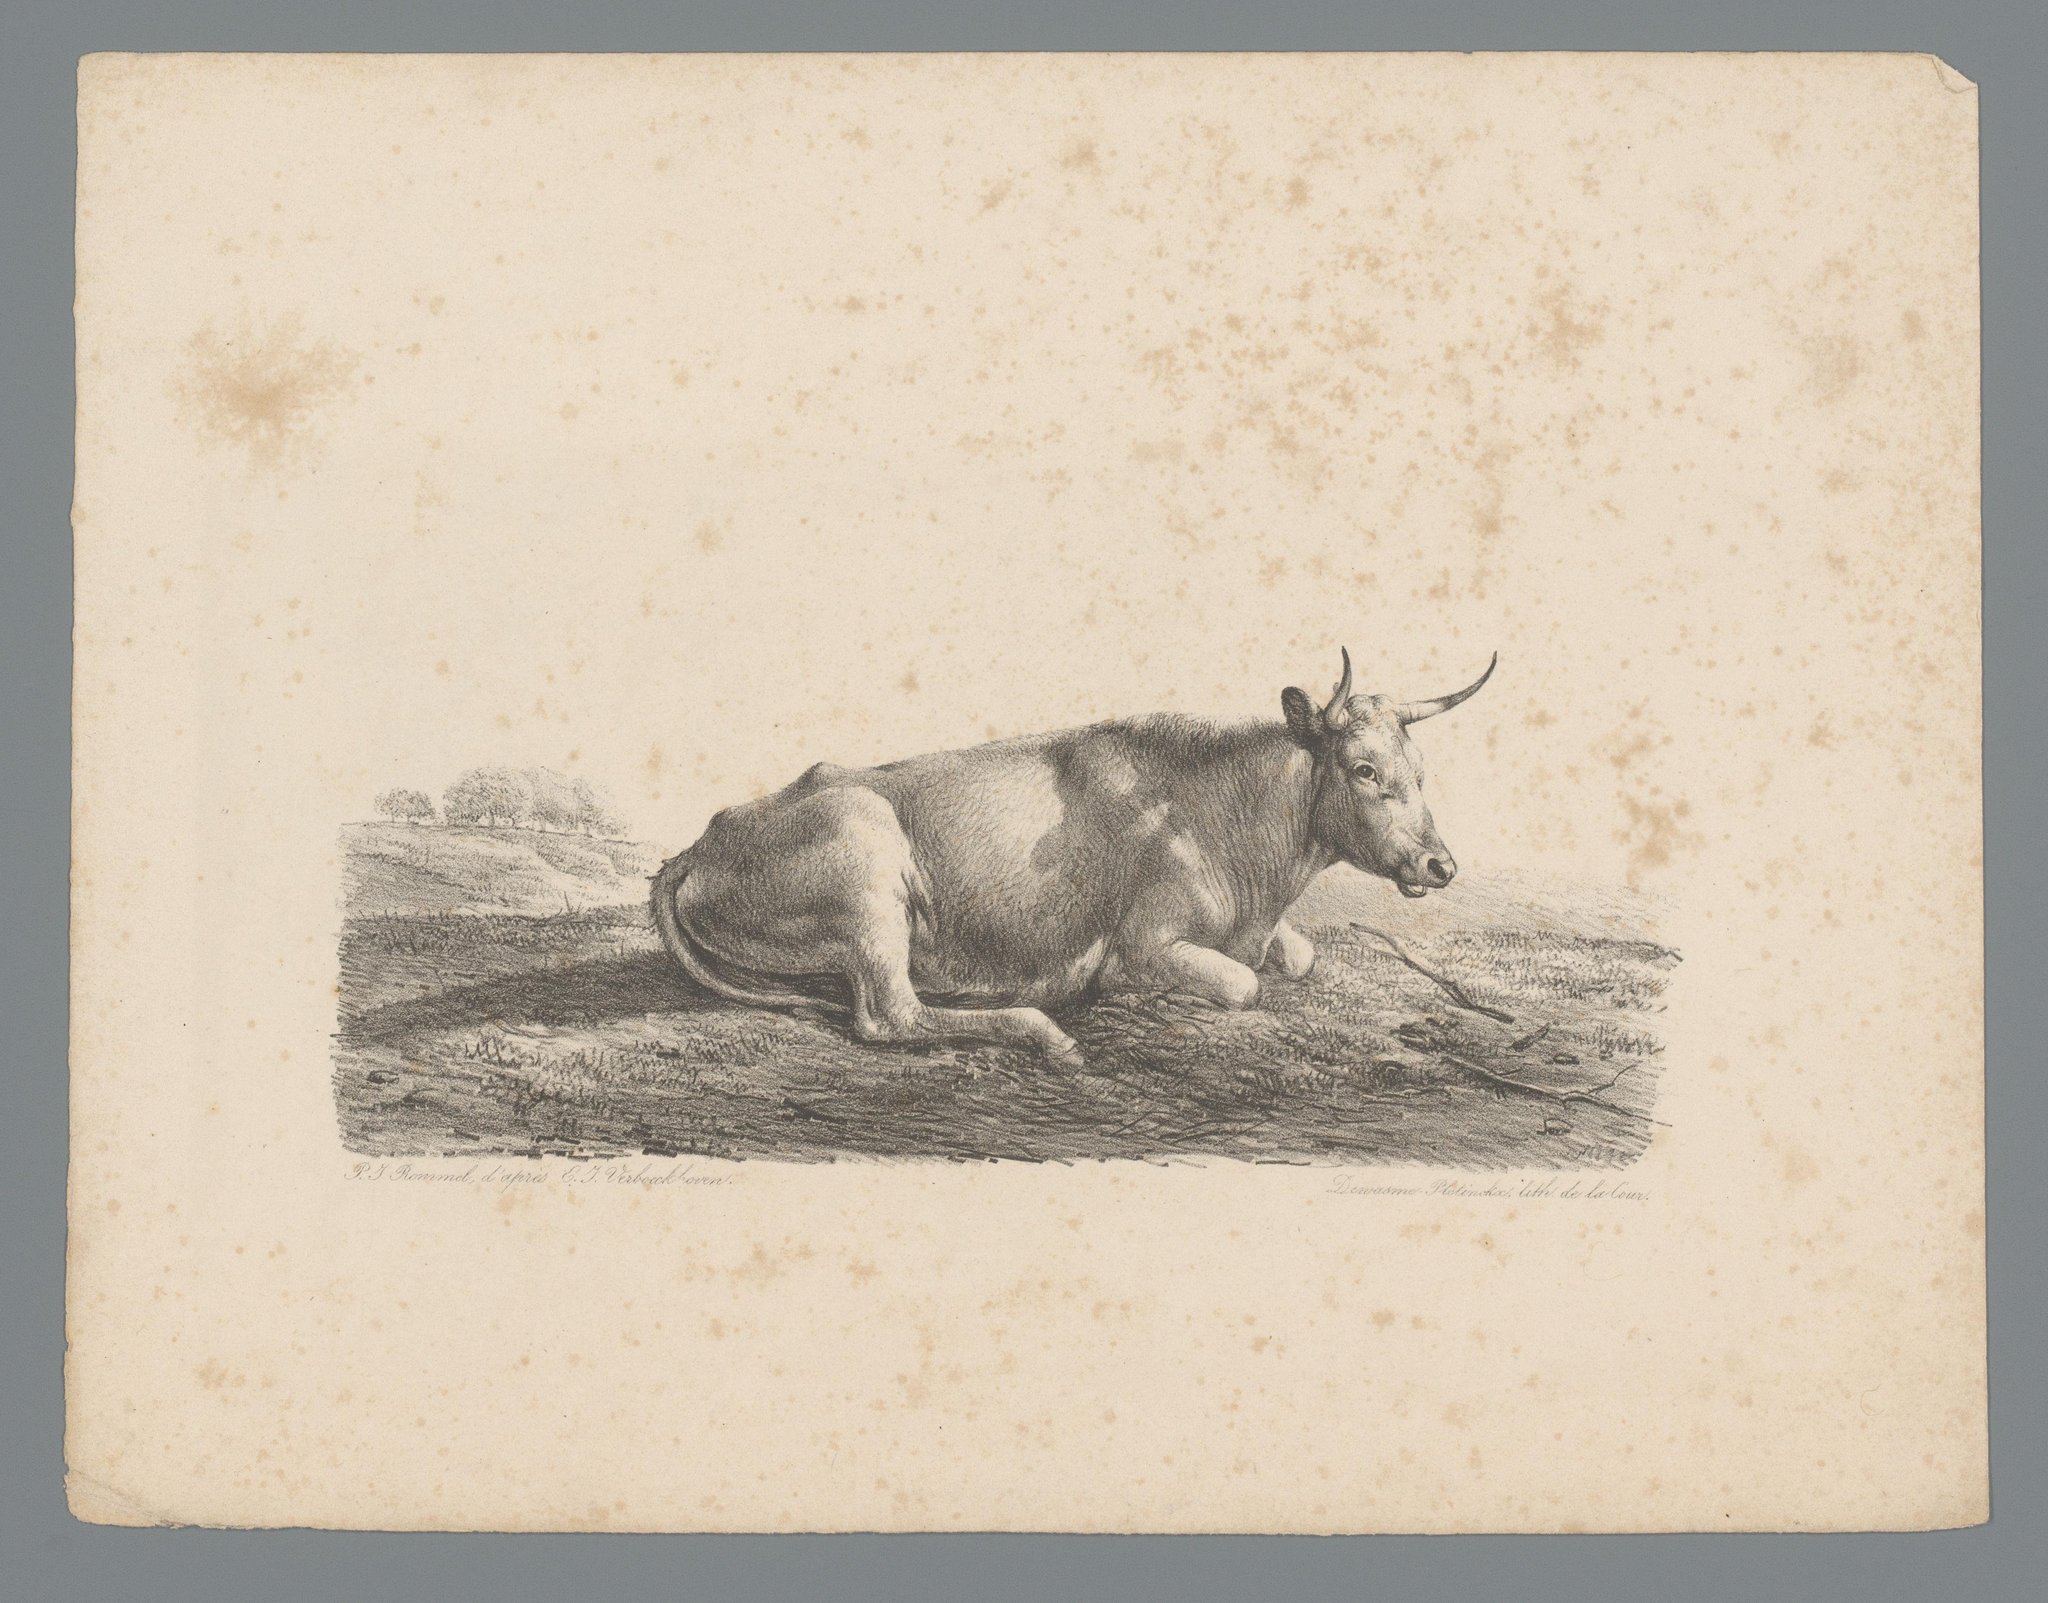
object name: print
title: Liggende koe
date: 1824-1827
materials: paper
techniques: lithograph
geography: brussels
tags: cow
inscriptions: collector's mark: Lugt 2228